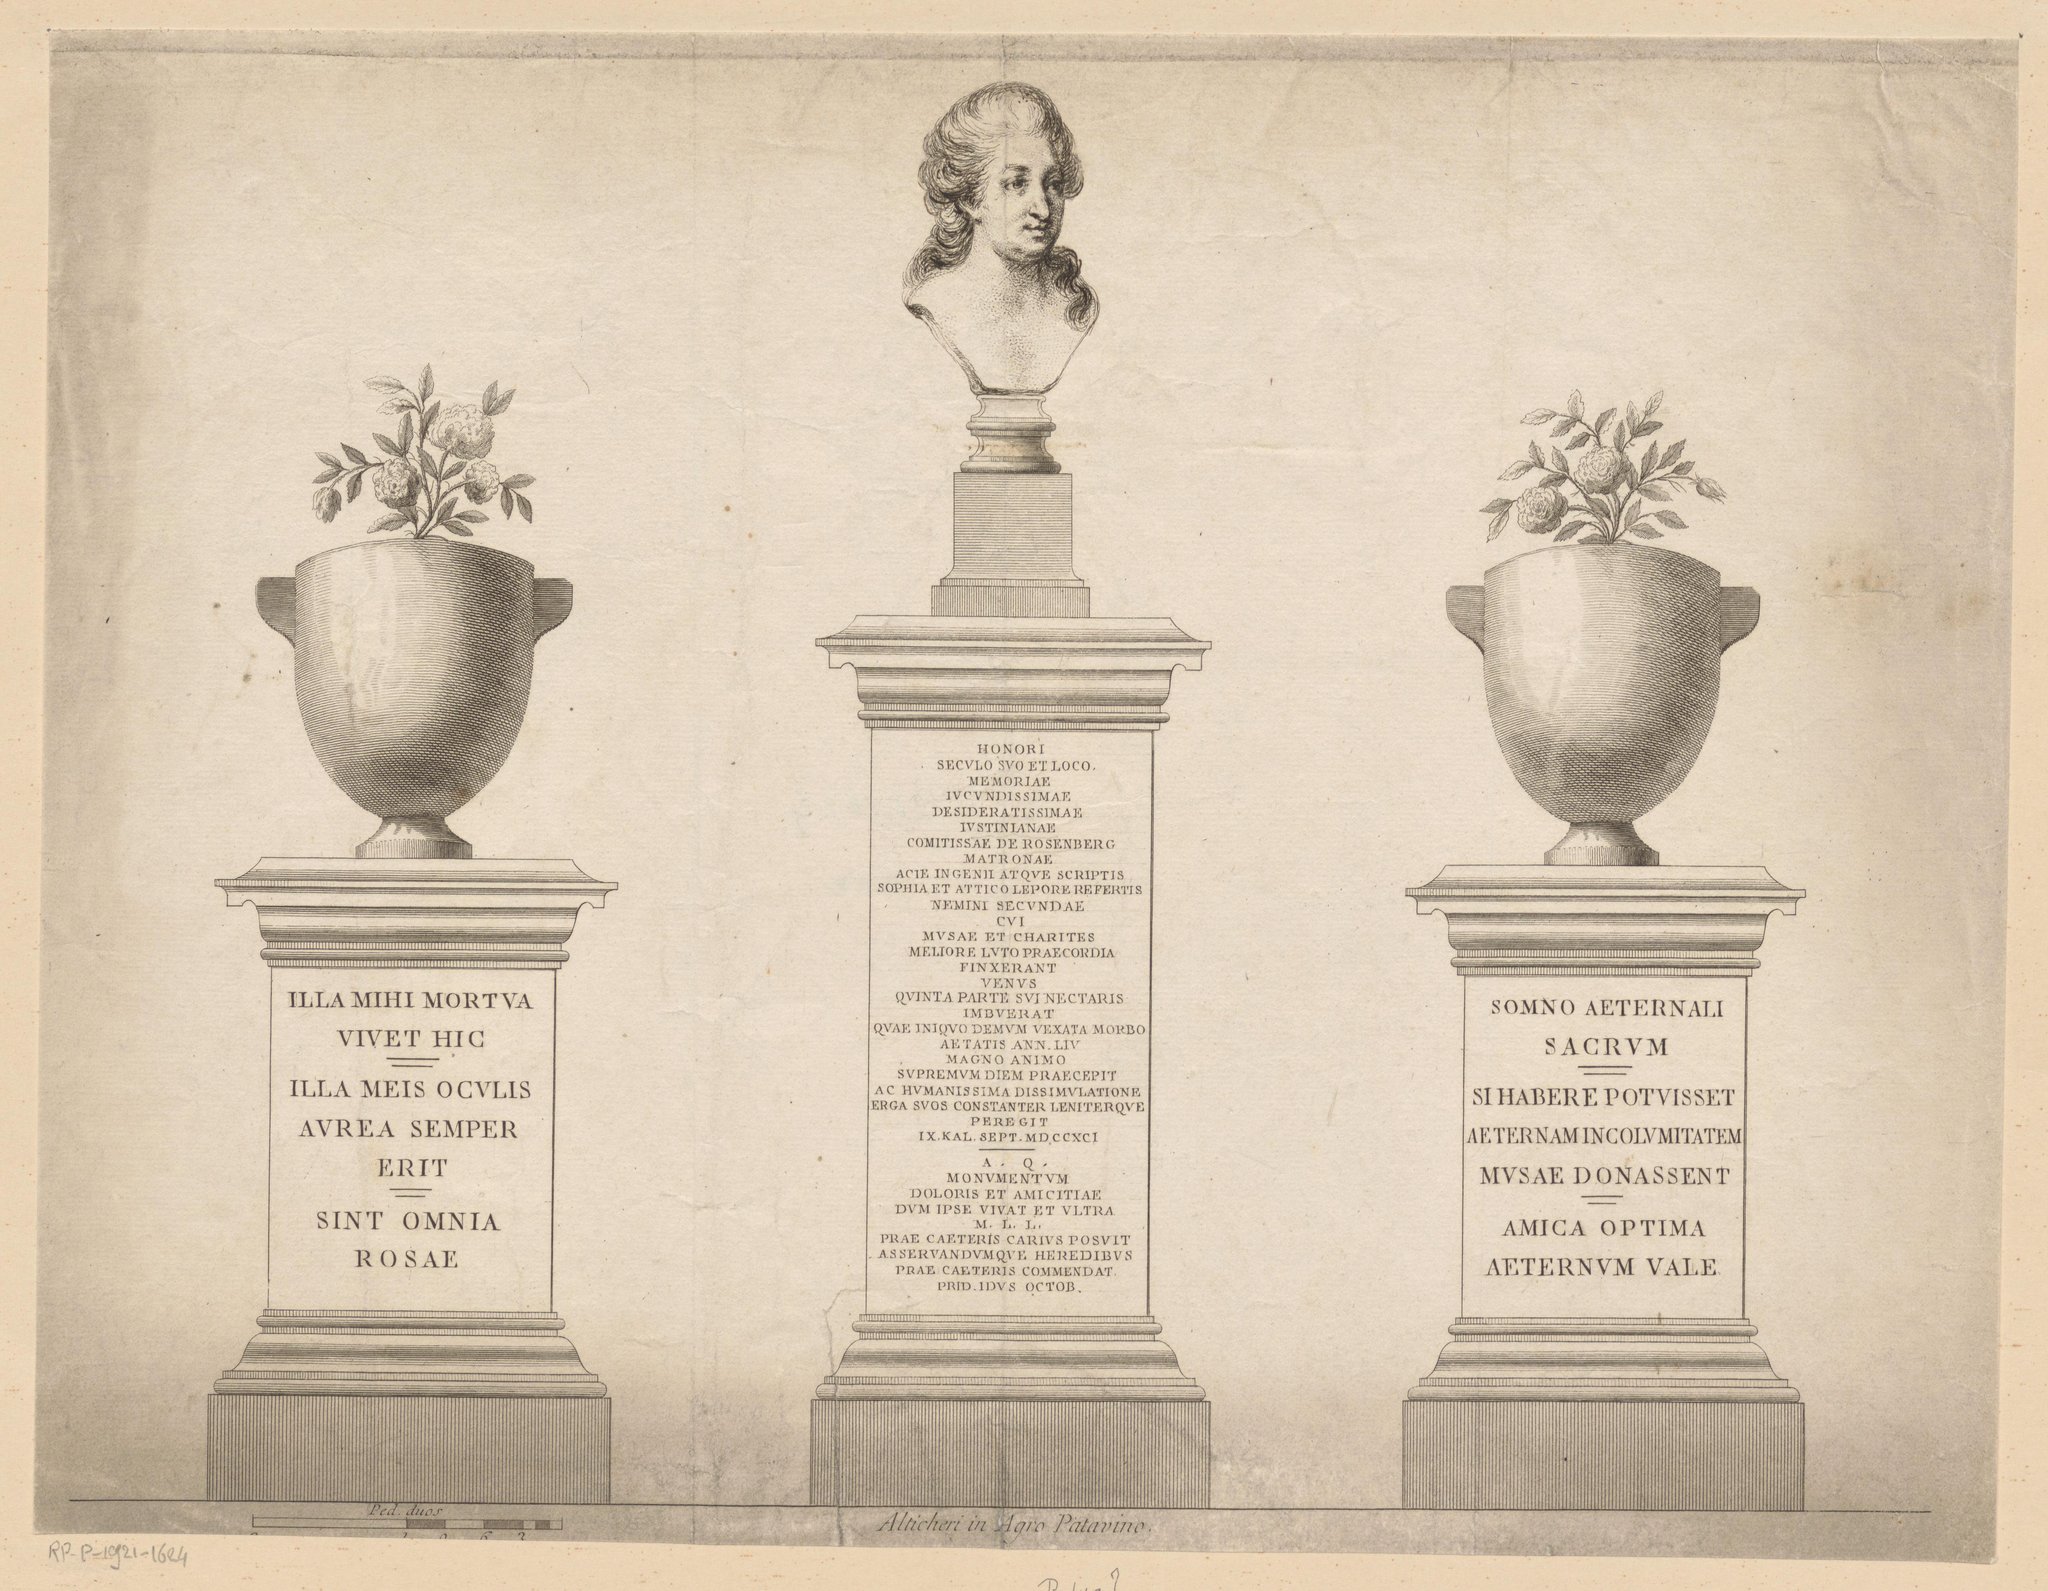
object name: print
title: Monument met het portret van Giustiniana Wynne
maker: Anonymous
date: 1791-1799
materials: paper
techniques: engraving, etching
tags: venice, flowers, historical persons, grave, tomb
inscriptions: collector's mark: Lugt 2233